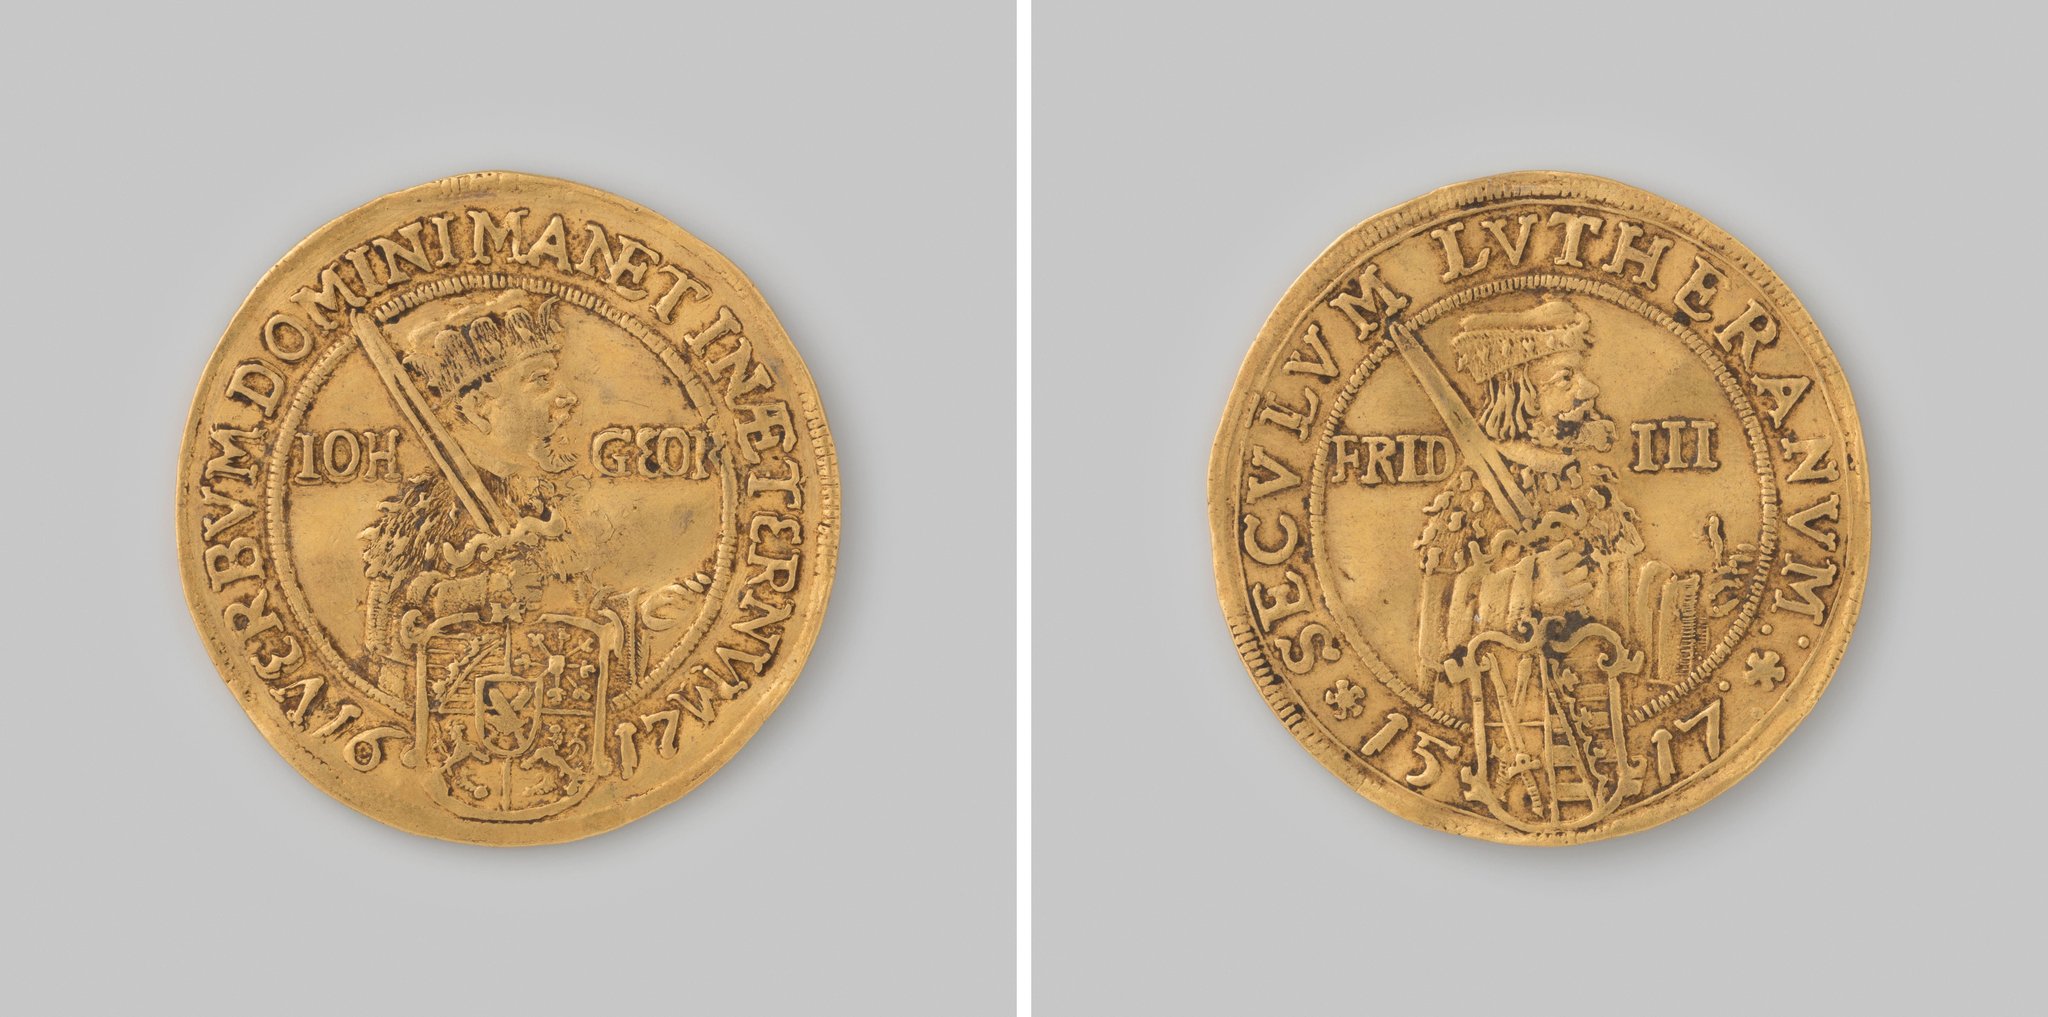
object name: dubbele dukaat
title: Dubbele dukaat uit Saksen, Albertinische Linie, van Johann Georg I, 1617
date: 1617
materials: gold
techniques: striking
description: Gouden munt. Voorzijde: tussen naamsaanduiding portret van de keurvorst naar rechts met in rechterhand zwaard. Daaronder tussen jaartal samengesteld wapenschild. Keerzijde: tussen naamsaanduiding FRID III portret van keurvorst Friedrich III naar rechts met in rechterhand zwaard. Daaronder tussen jaartal 1517 samengesteld wapenschild. Omschrift: SECVLVM LVTHERANVM. Geslagen ter herinnering aan een Eeuw Lutheranisme.